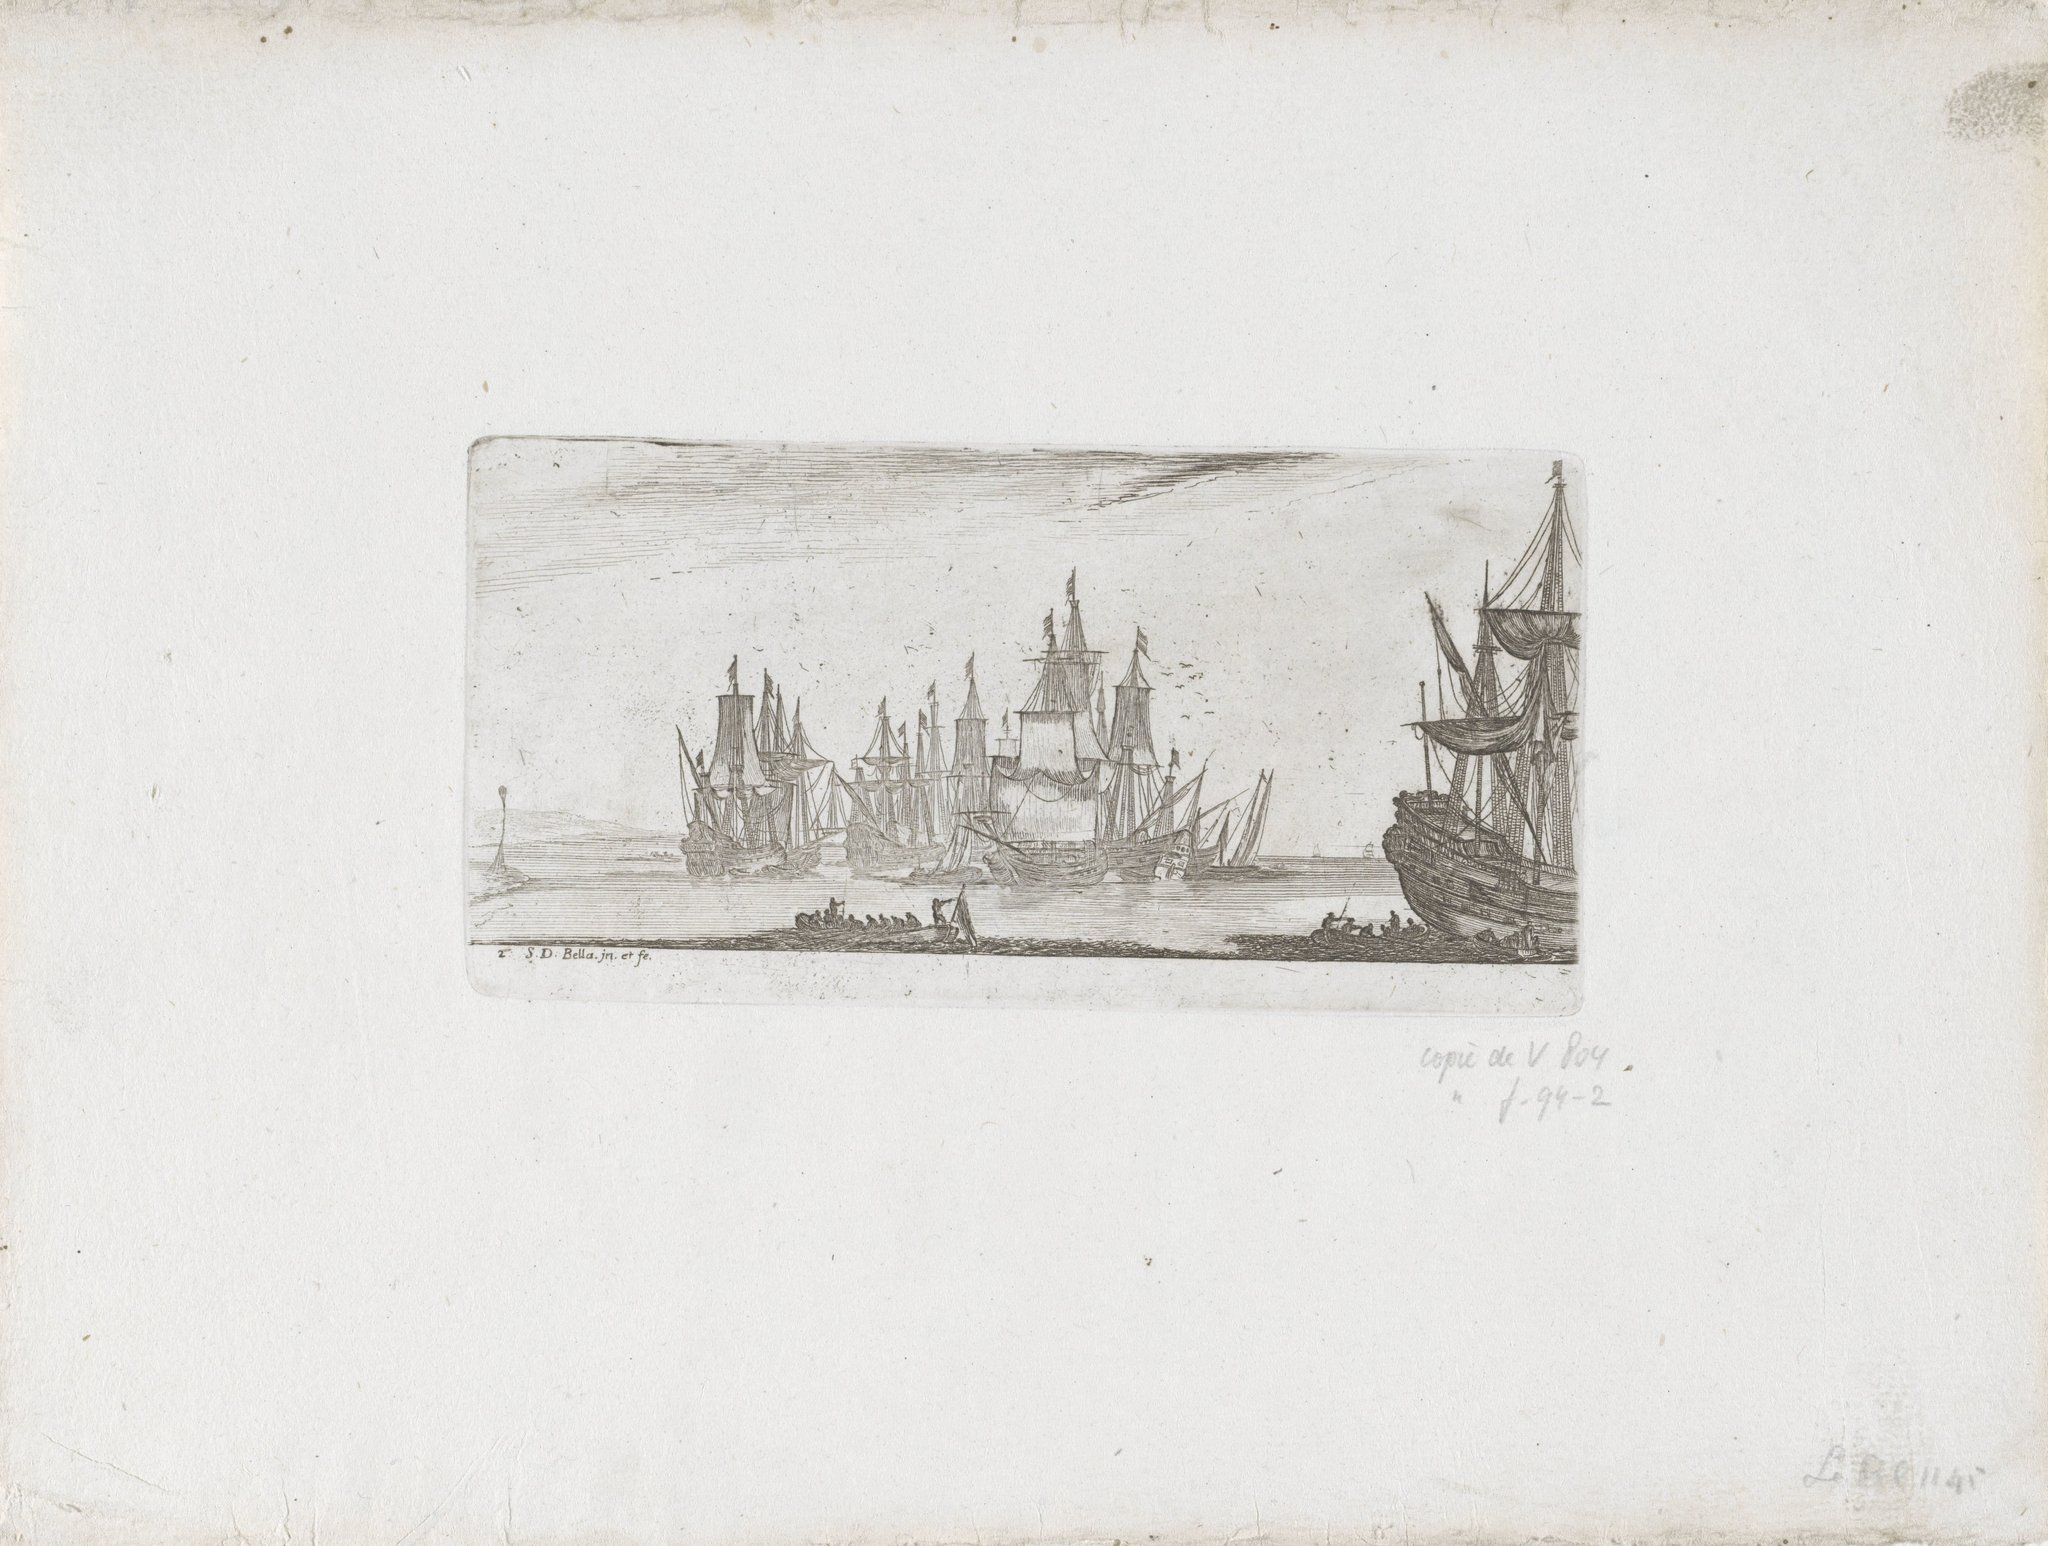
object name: print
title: Schepen op de rede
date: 1620-1664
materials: paper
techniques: etching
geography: rome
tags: ships (in general), ship bound for the harbour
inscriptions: collector's mark: Lugt 2228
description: Prent uit een reeks van negen prenten. Zeven prenten zijn spiegelbeeldige en genummerde kopieën naar prenten van Stefano della Bella. Twee prenten zijn nieuwe inventies. Mogelijk is deze gekopieerde reeks ook door Della Bella zelf vervaardigd.